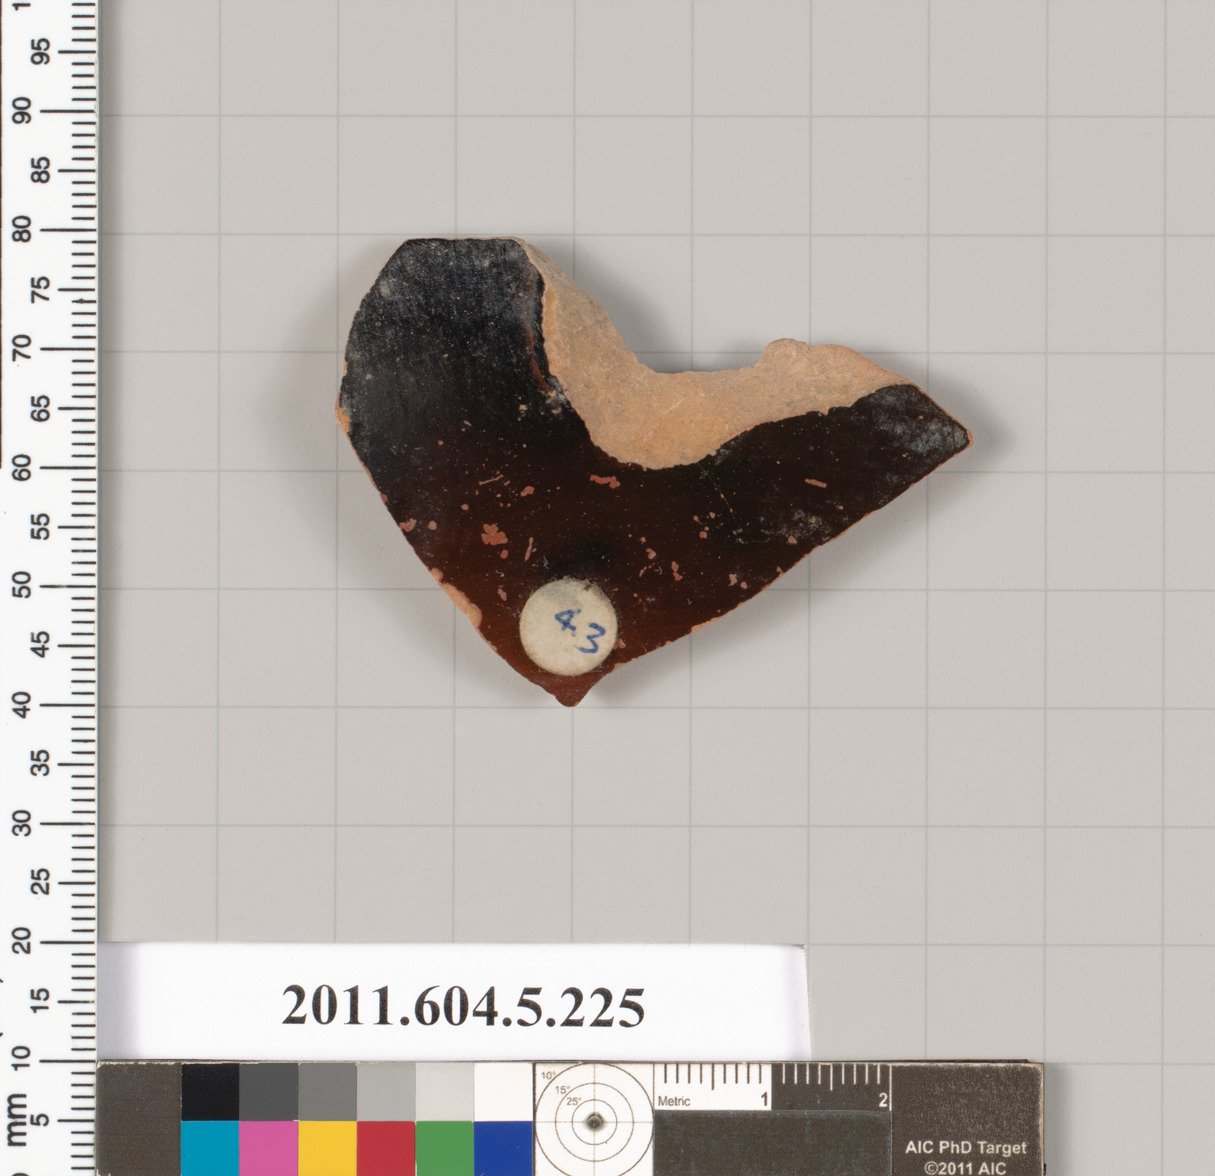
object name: kylix fragment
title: Terracotta fragment of a kylix (drinking cup)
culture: greek, attic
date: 600-401 BCE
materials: terracotta